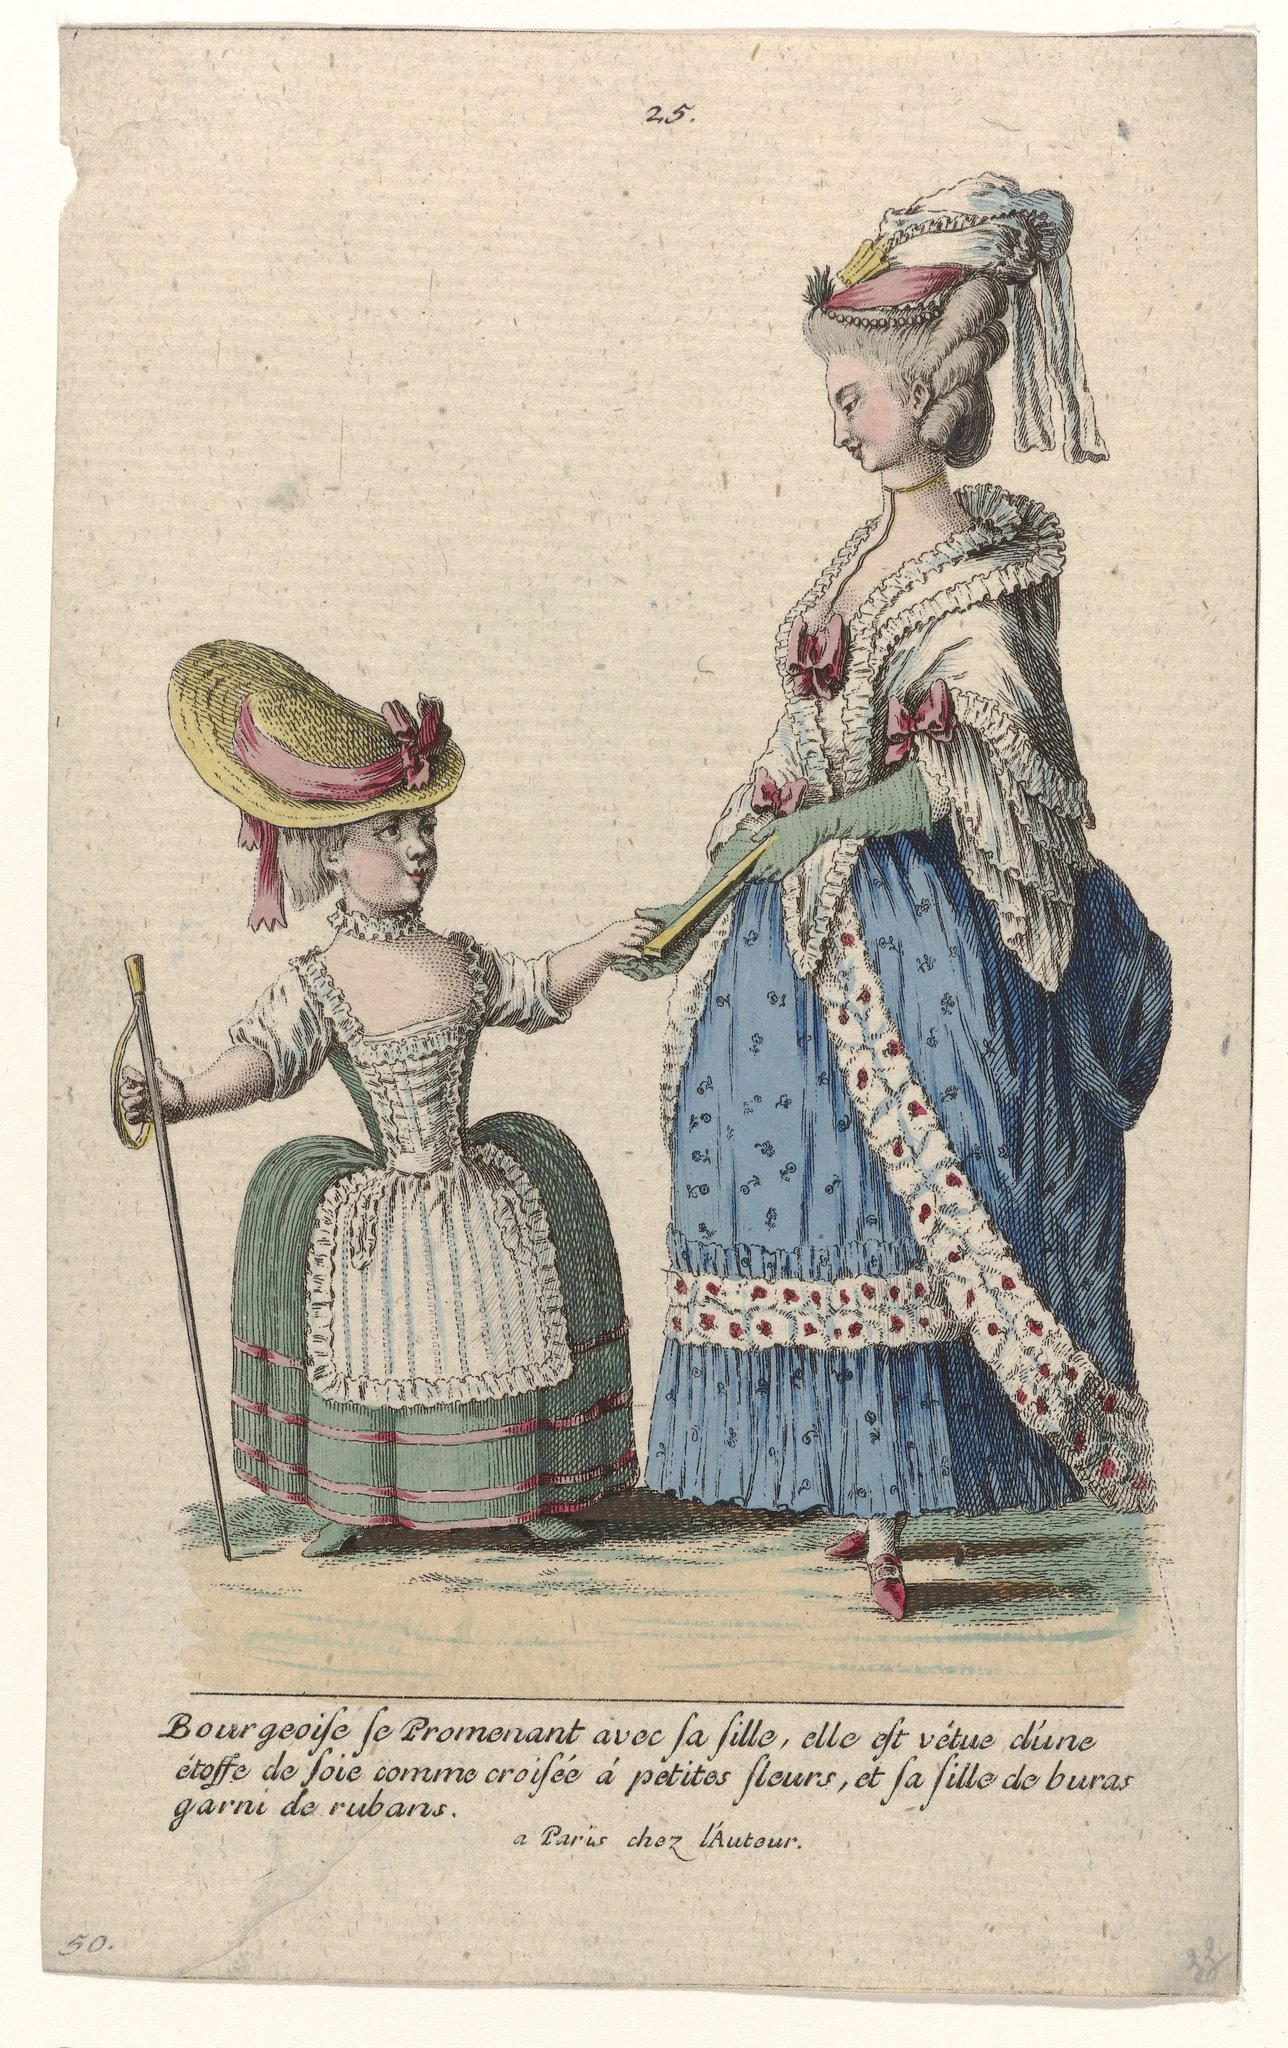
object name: fashion print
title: Gallerie des Modes et Costumes Français, 1785, nr. 25, nr. 50, Kopie naar H 45 : Bourgeoise se promenant avec sa fill (...)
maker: pierre gleich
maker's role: print maker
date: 1785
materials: paper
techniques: engraving, hand coloring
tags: skirt (+ girls' clothes), gloves, mittens (long gloves) (+ women's clothes), walking-stick, staff, cane (+ girls' clothes), apron (+ girls' clothes), head-gear (+ girls' clothes), neck-gear ~ clothing (+ girls' clothes), clothing for the upper part of the body (mantelet) (+ women's clothes), head-gear: cap (+ women's clothes), fashion plates, skirt (+ women's clothes), dress, gown (+ women's clothes), neck-gear ~ clothing (+ women's clothes)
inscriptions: caption: ‘Bourgeoise se promenant avec sa fille, elle est vétue d'une étoffe de Soie comme croisée á petites fleurs, et sa fille de buras garni de rubans.’, caption: ‘a Paris chez l'Auteur.’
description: Burgervrouw, wandelend met haar dochter aan de hand. Zij draagt een kleine schoudermantel versierd met strikken op een japon van zijde met bloemmotief. Accessoires: muts met slippen, om de hals een koord of lint, lange handschoenen, waaier, schoenen met gespen. Het meisje draagt een japon met vierkante hals, de rok versierd met linten. Gestreept sierschort. Accessoires: hoed versierd met lint, om de hals een gerimpeld lint (collerette), wandelstok met lint en schoenen. Kopie naar H 45 uit serie H. 8e Cahier de Costumes Français, 2e Suite d'Habillemens de Femmes à la mode, Gallerie des Modes et Costumes Français.